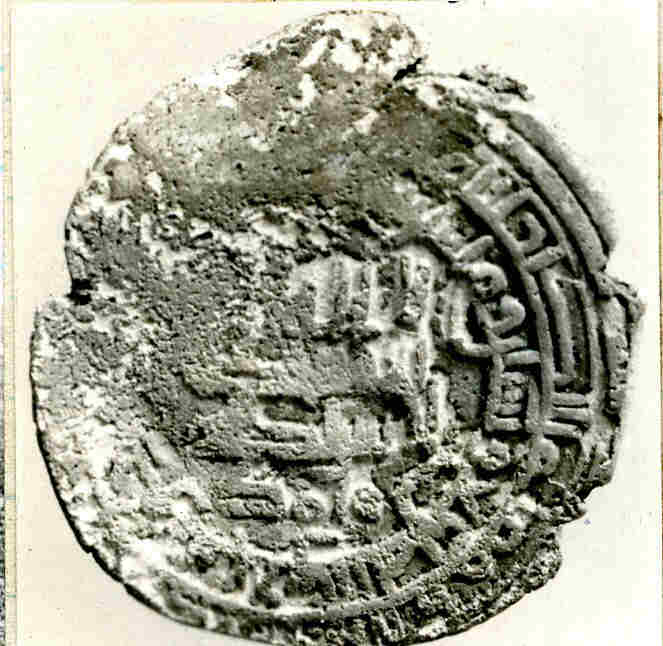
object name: coin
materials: silver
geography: balkh